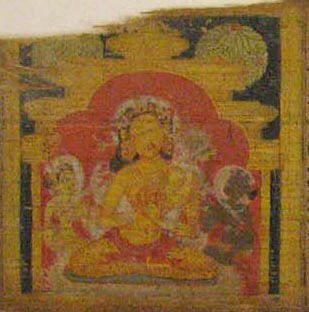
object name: folio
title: Folio from a Buddhist Manuscript of Pancavimsatisahasrika Prajnaparamita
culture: indian, bengal or bangladesh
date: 1090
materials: leaf, watercolor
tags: buddhism